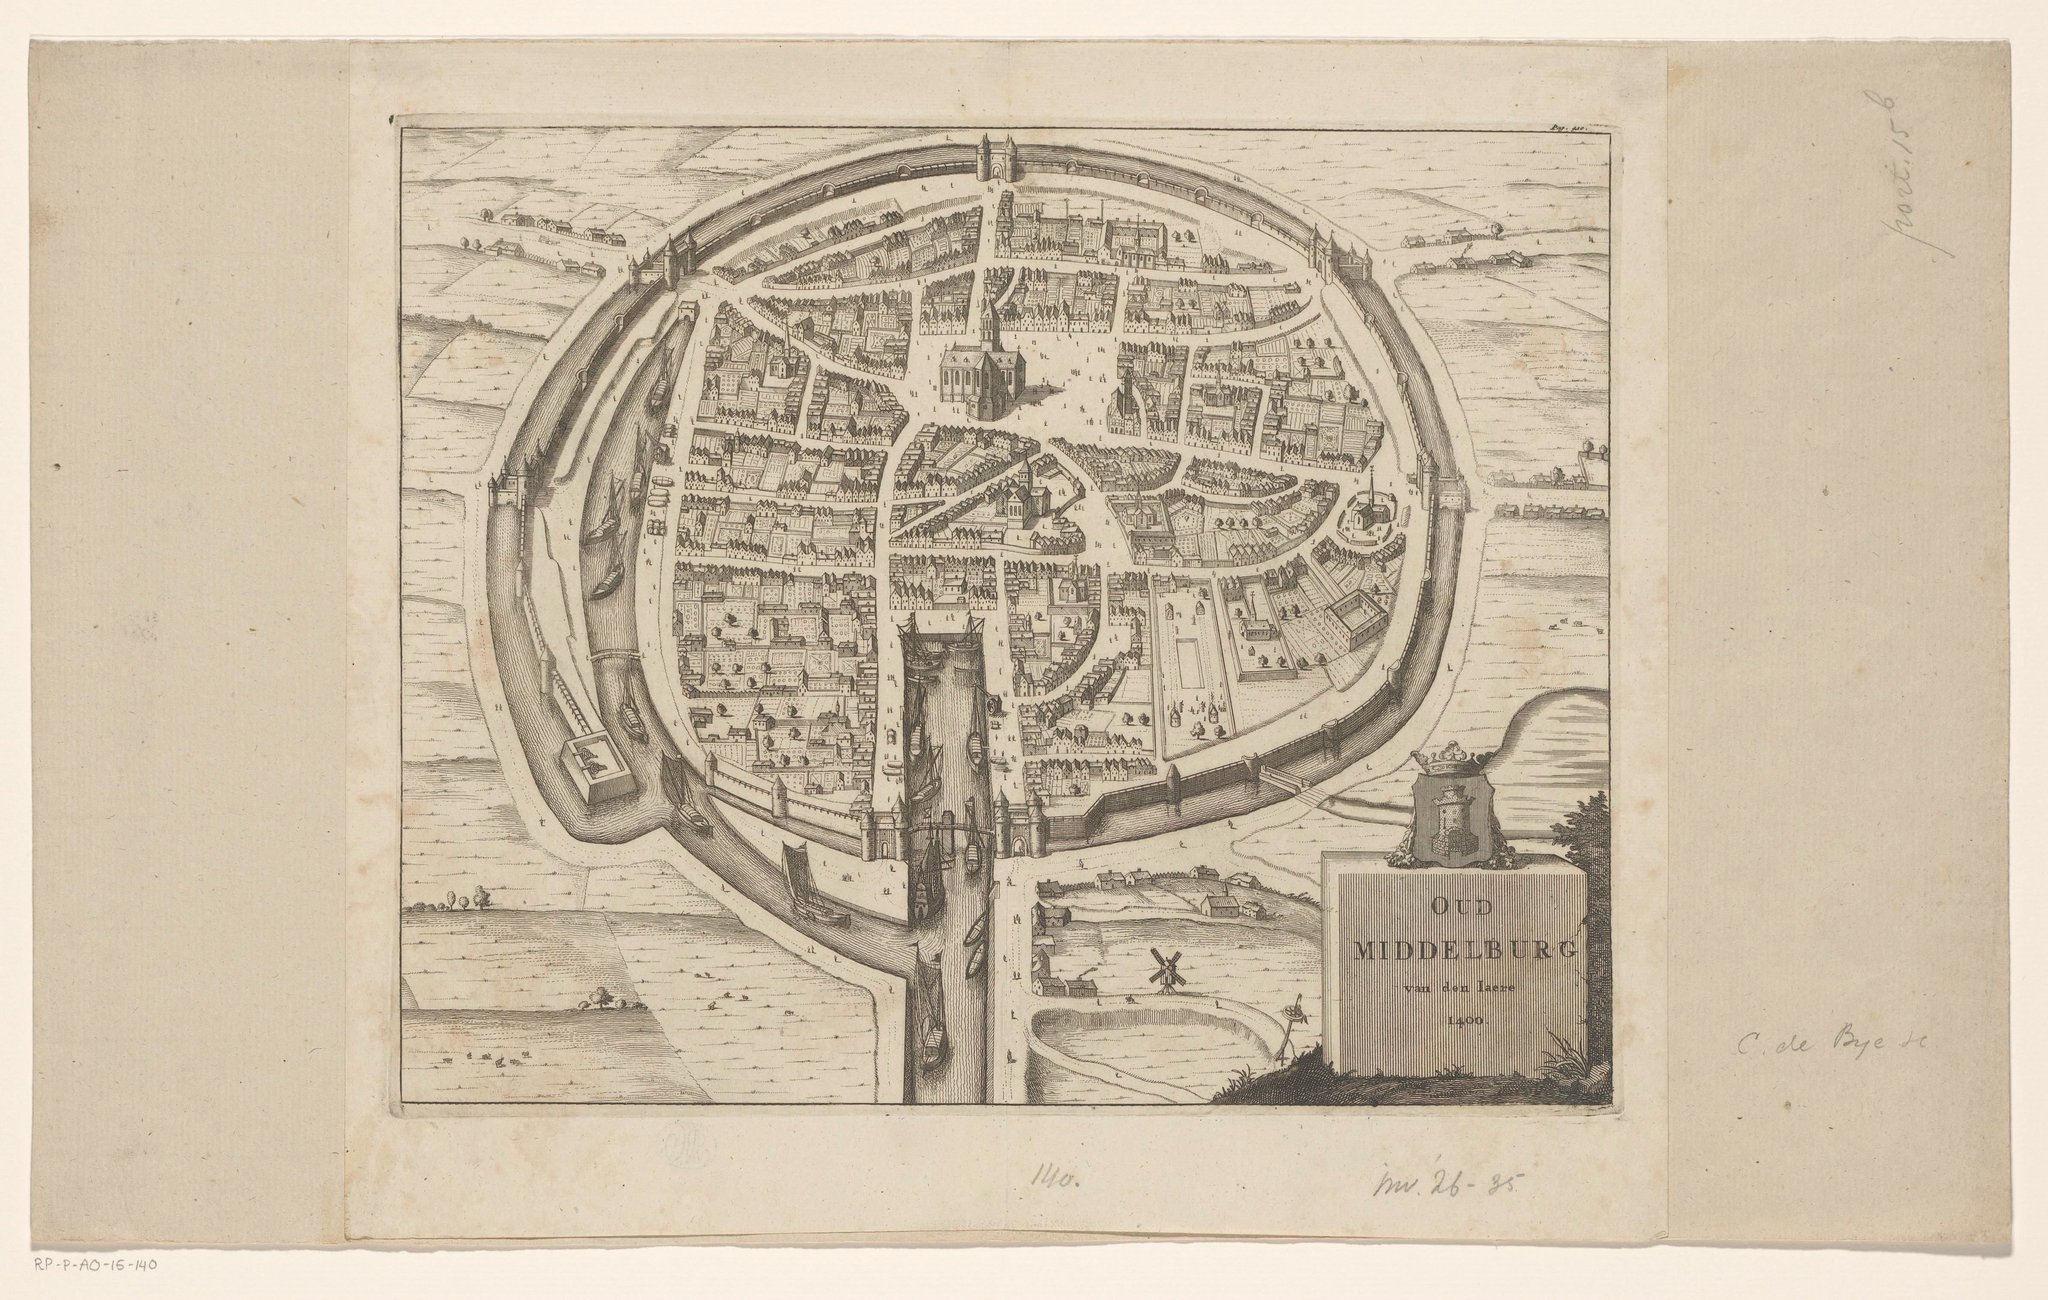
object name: print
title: Oud Middelburg van den Iaere 1400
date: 1696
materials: paper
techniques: etching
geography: amsterdam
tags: coat of arms (as symbol of the state, etc.) (+ city; municipal), maps of cities, middelburg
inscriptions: collector's mark: Lugt 195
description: Huidige staat van prent ook gebruikt in: Smallegange, Mattheus. Nieuwe Cronyk van Zeeland (…). Middelburg en Amsterdam: Johannes Meertens en Abraham van Someren, 1696. Latere staat van prent (zonder nummering rechtsboven) ook gebruikt in: Aa, Pieter van der. La galerie agreable du monde (...). 66 delen. Leiden: Pieter van der Aa, 1728, dl. 20.